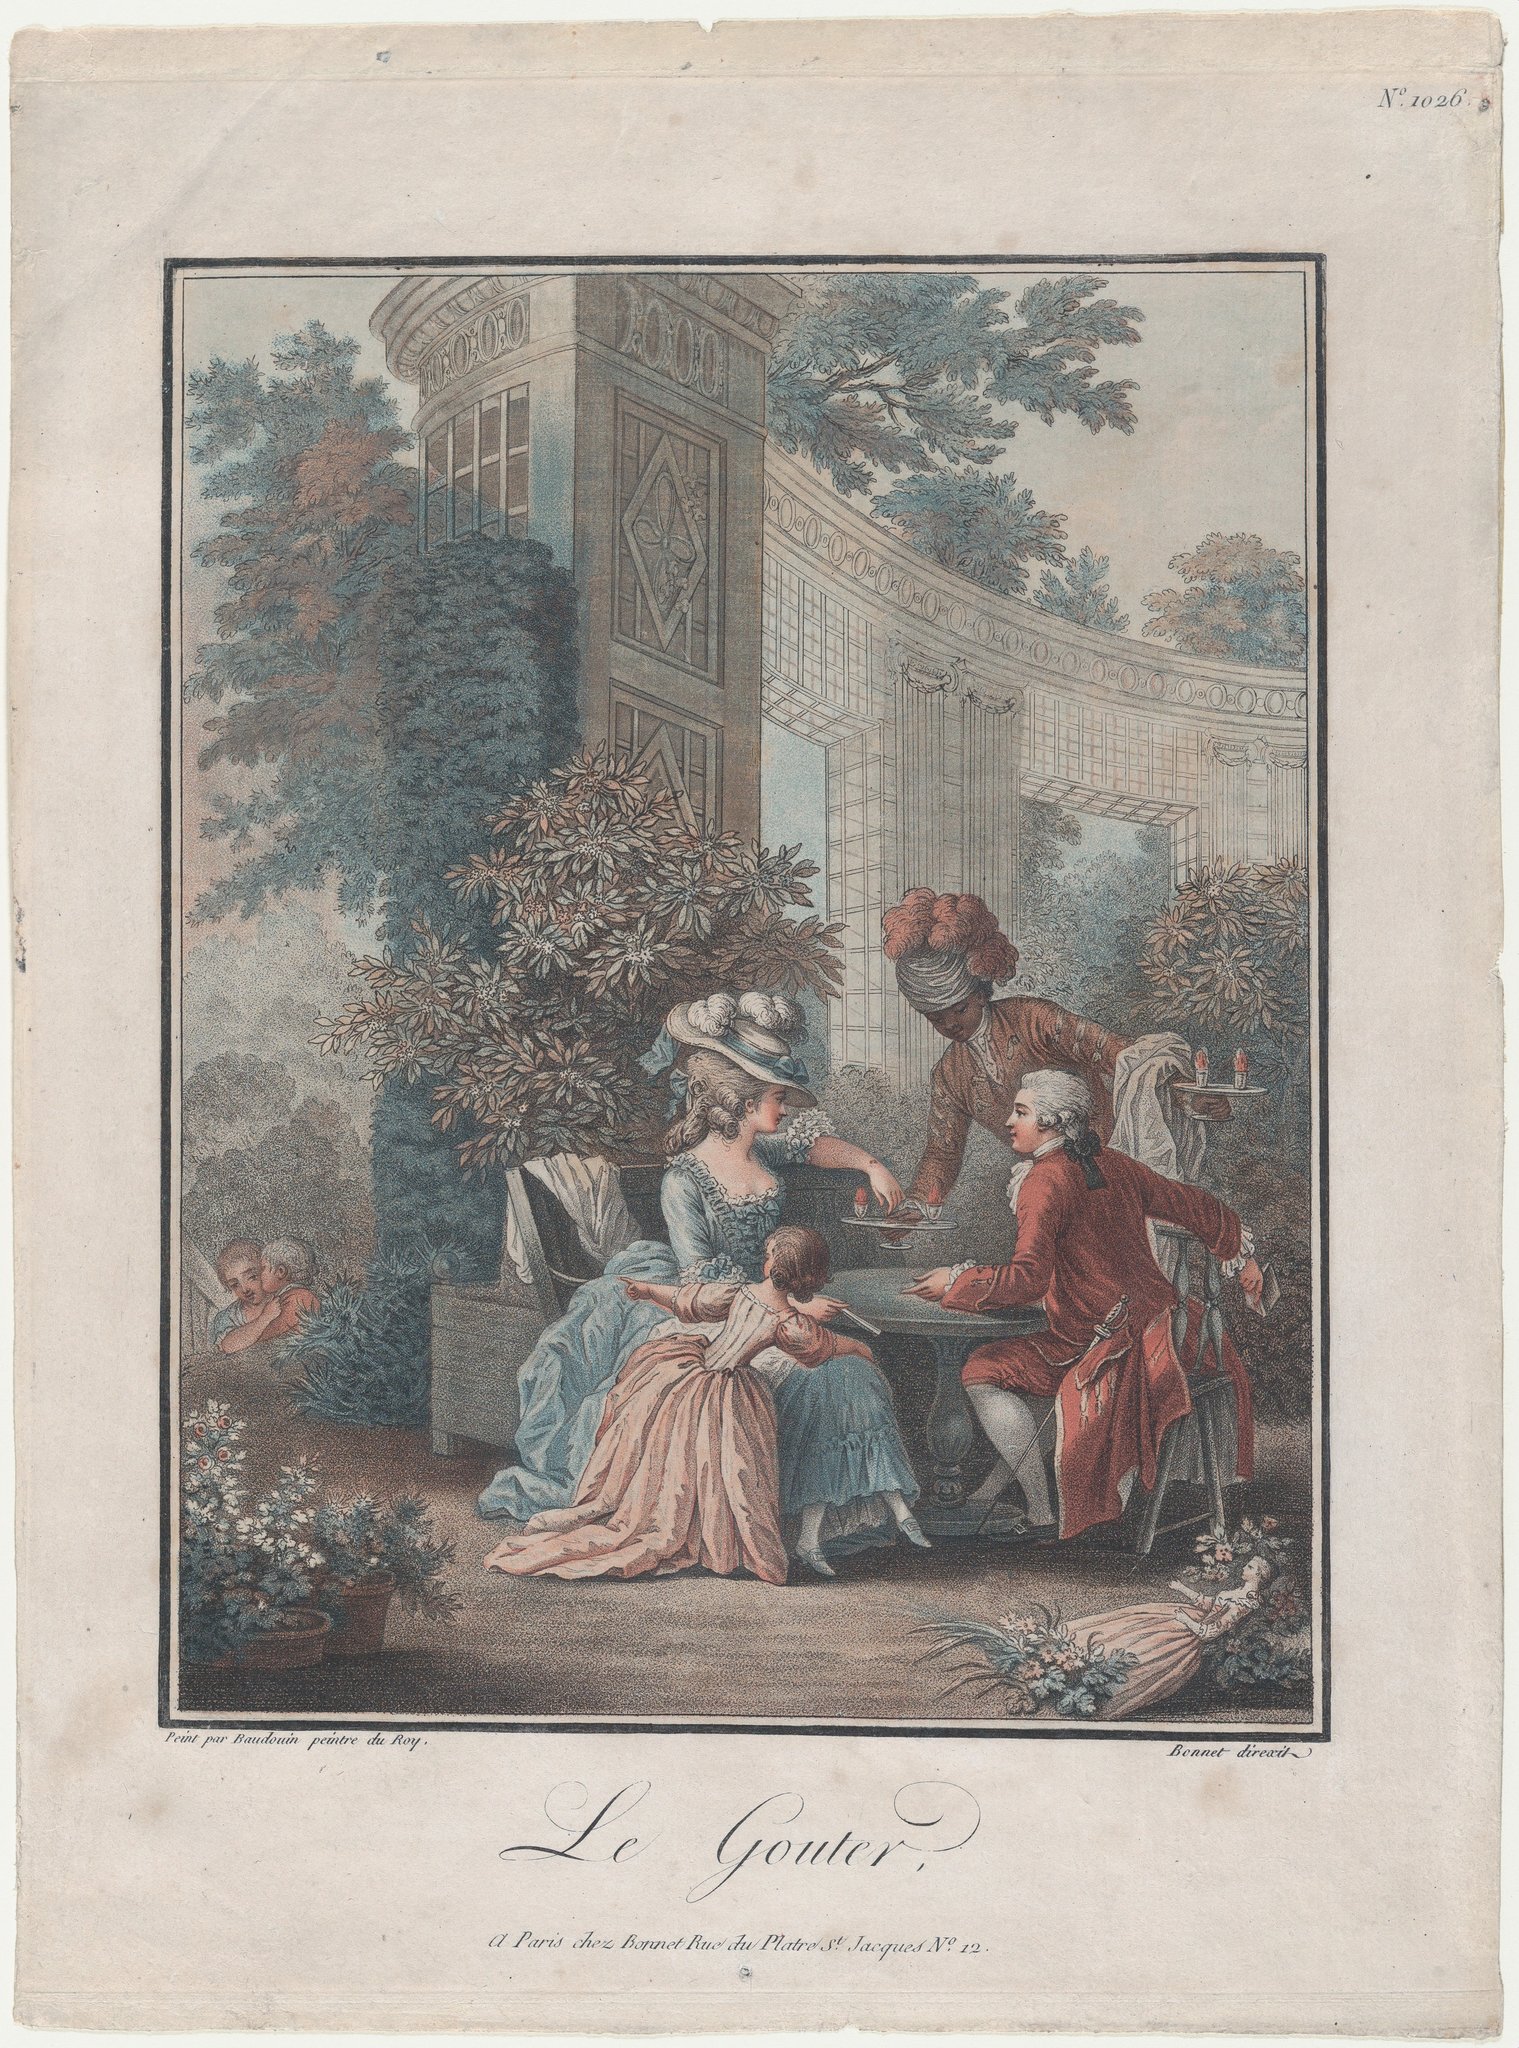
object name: print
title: The Snack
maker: louis marin bonnet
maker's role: artist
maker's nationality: french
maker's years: 1736-1793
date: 1787-1793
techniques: stippling, wash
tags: girls,men,women,dolls,plants